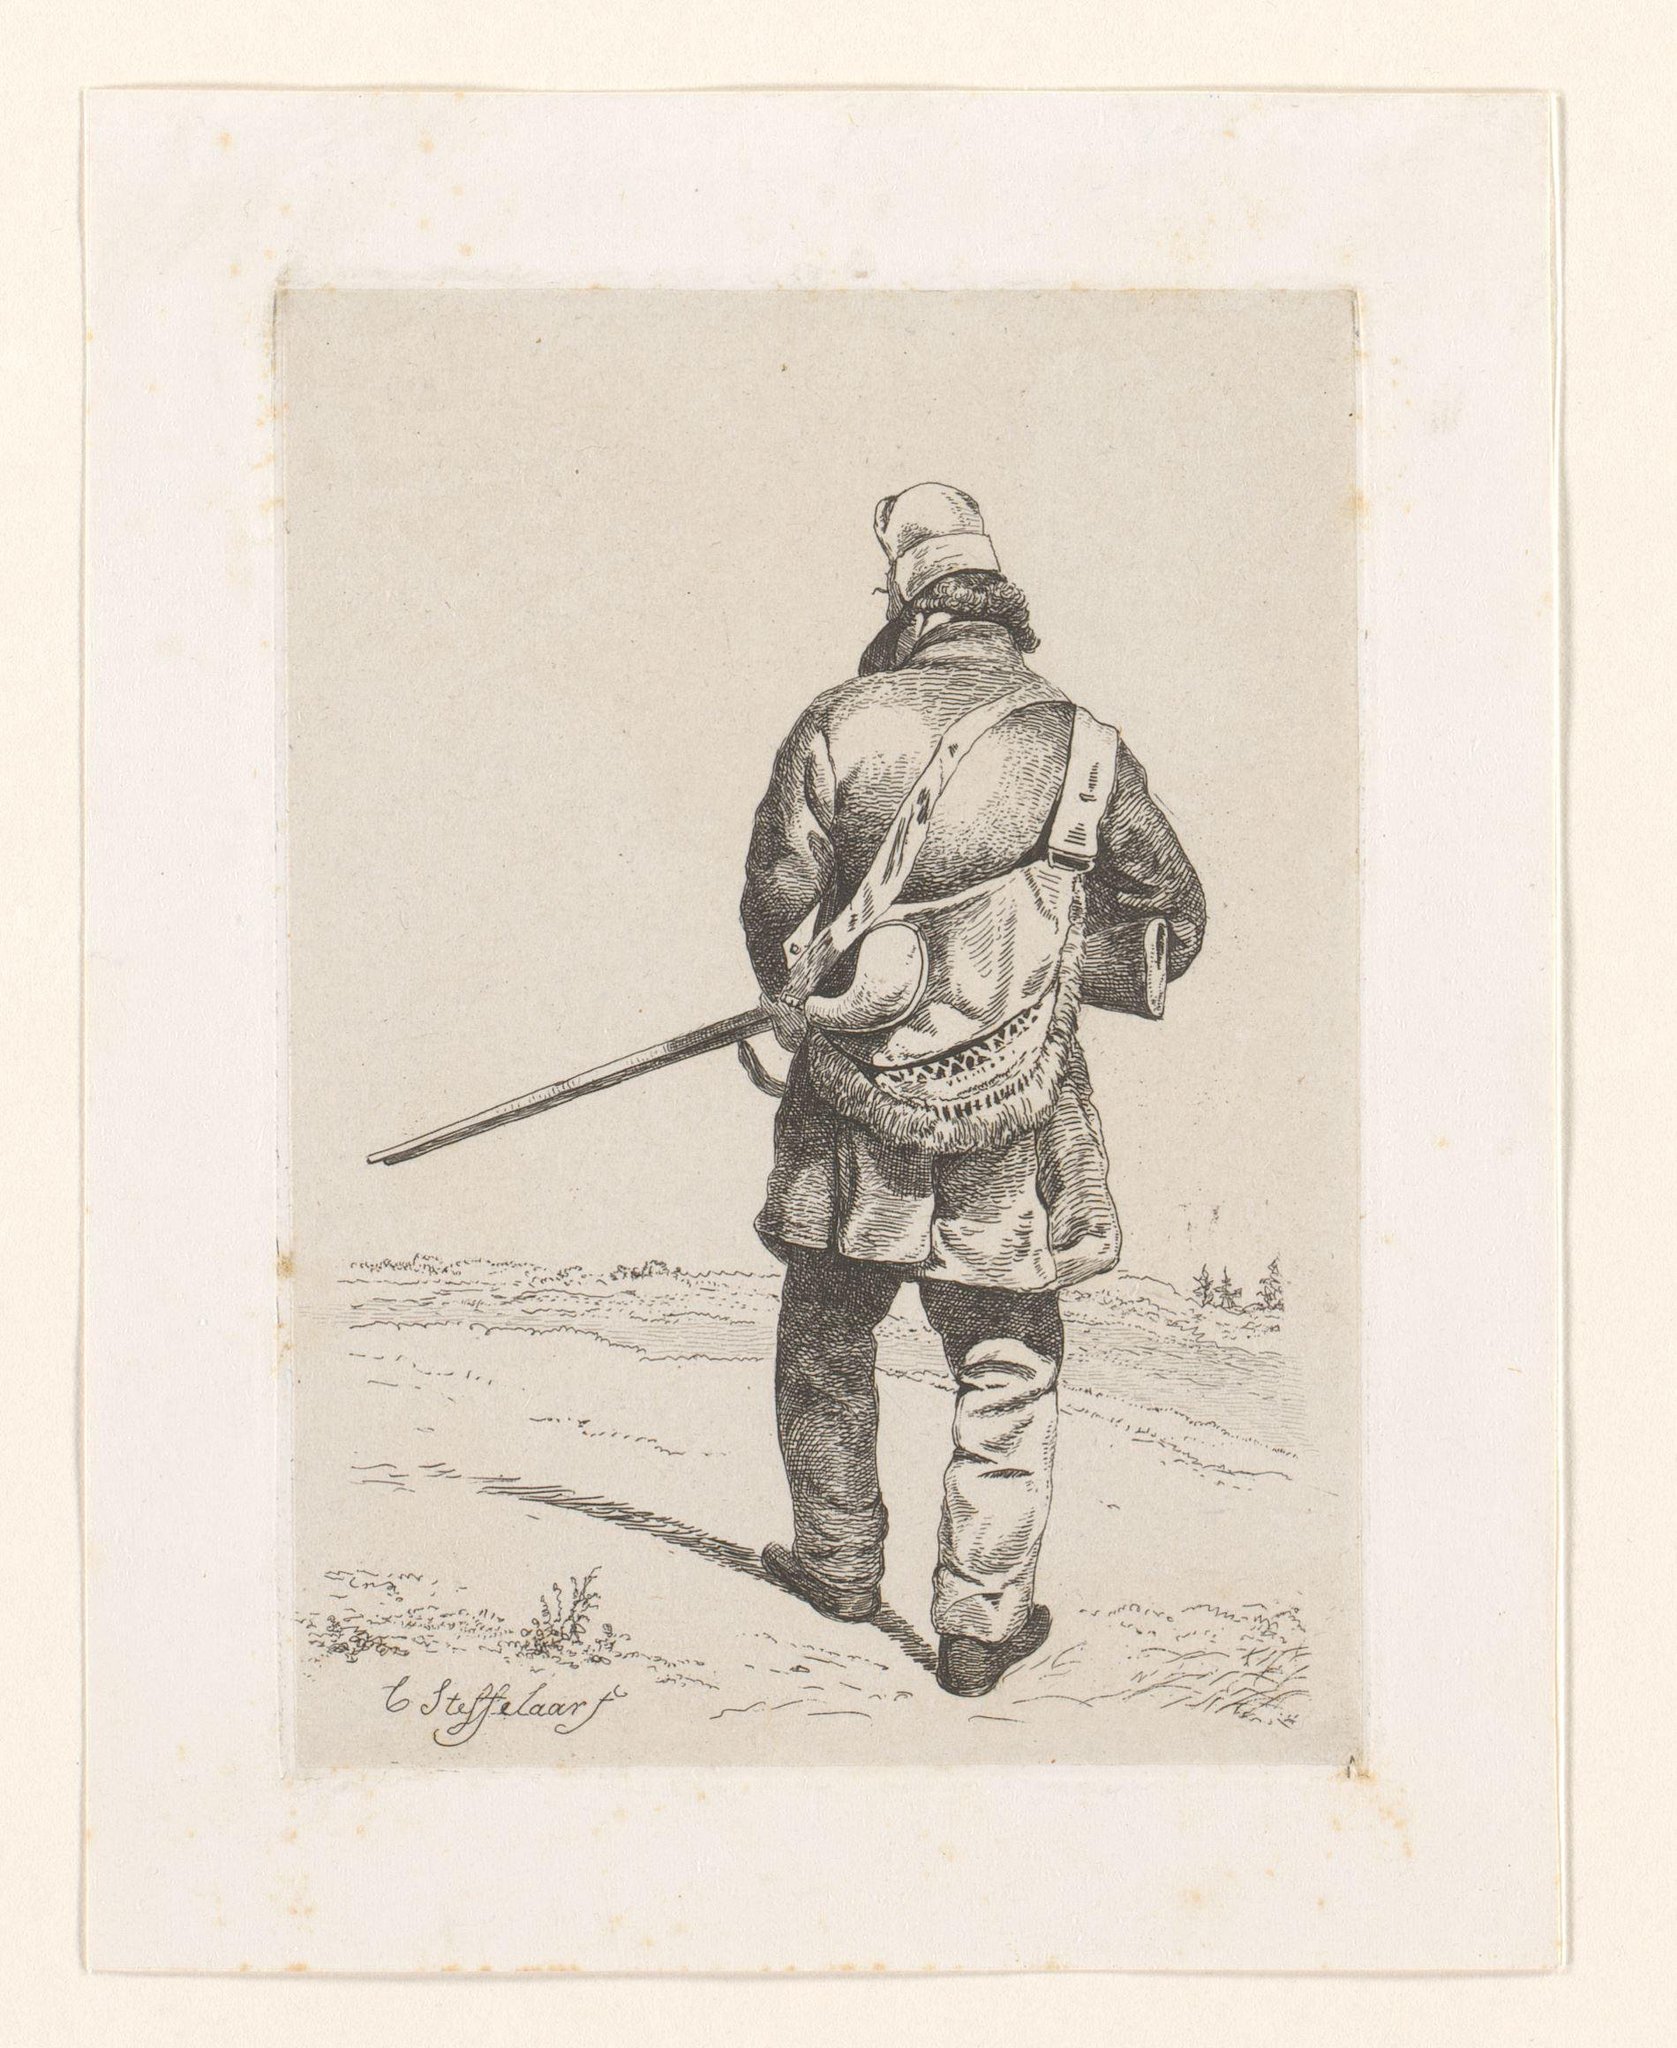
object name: print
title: Jager op de rug gezien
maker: cornelis steffelaar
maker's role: draughtsman, painter, print maker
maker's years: 1797-1861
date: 1807-1861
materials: paper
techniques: etching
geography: amsterdam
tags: hunter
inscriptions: collector's mark: Lugt 2228, collector's mark: Lugt 1485, number: ‘31’